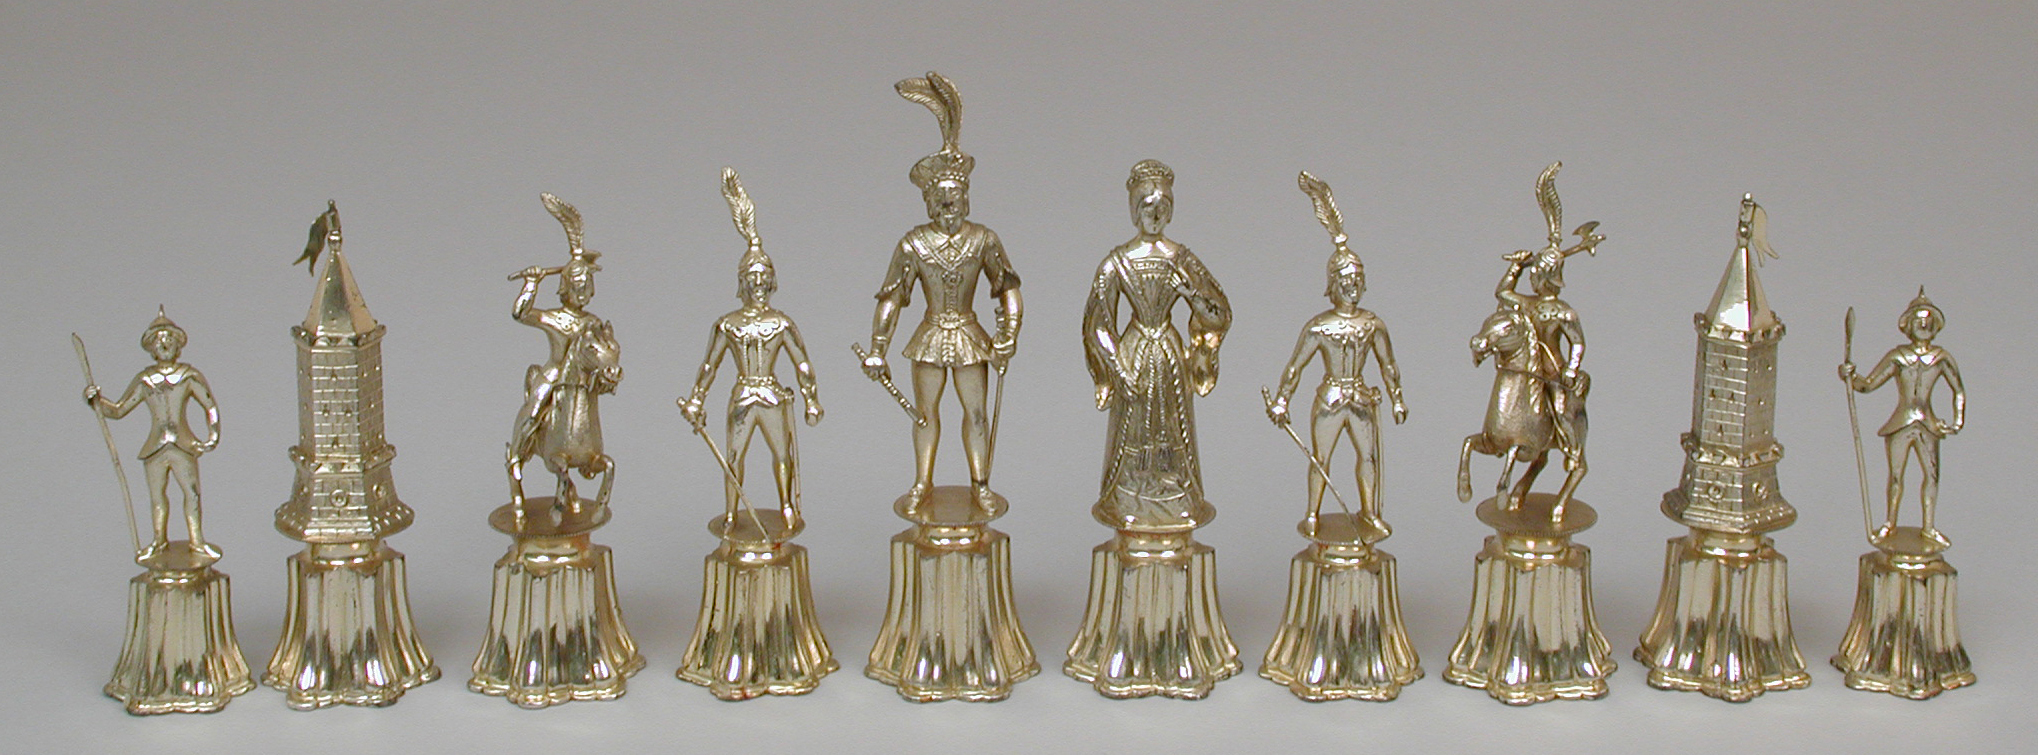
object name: chessman and board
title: Chessmen (32) and board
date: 1840-1850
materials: silver, silver gilt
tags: kings,queens,chess,horses